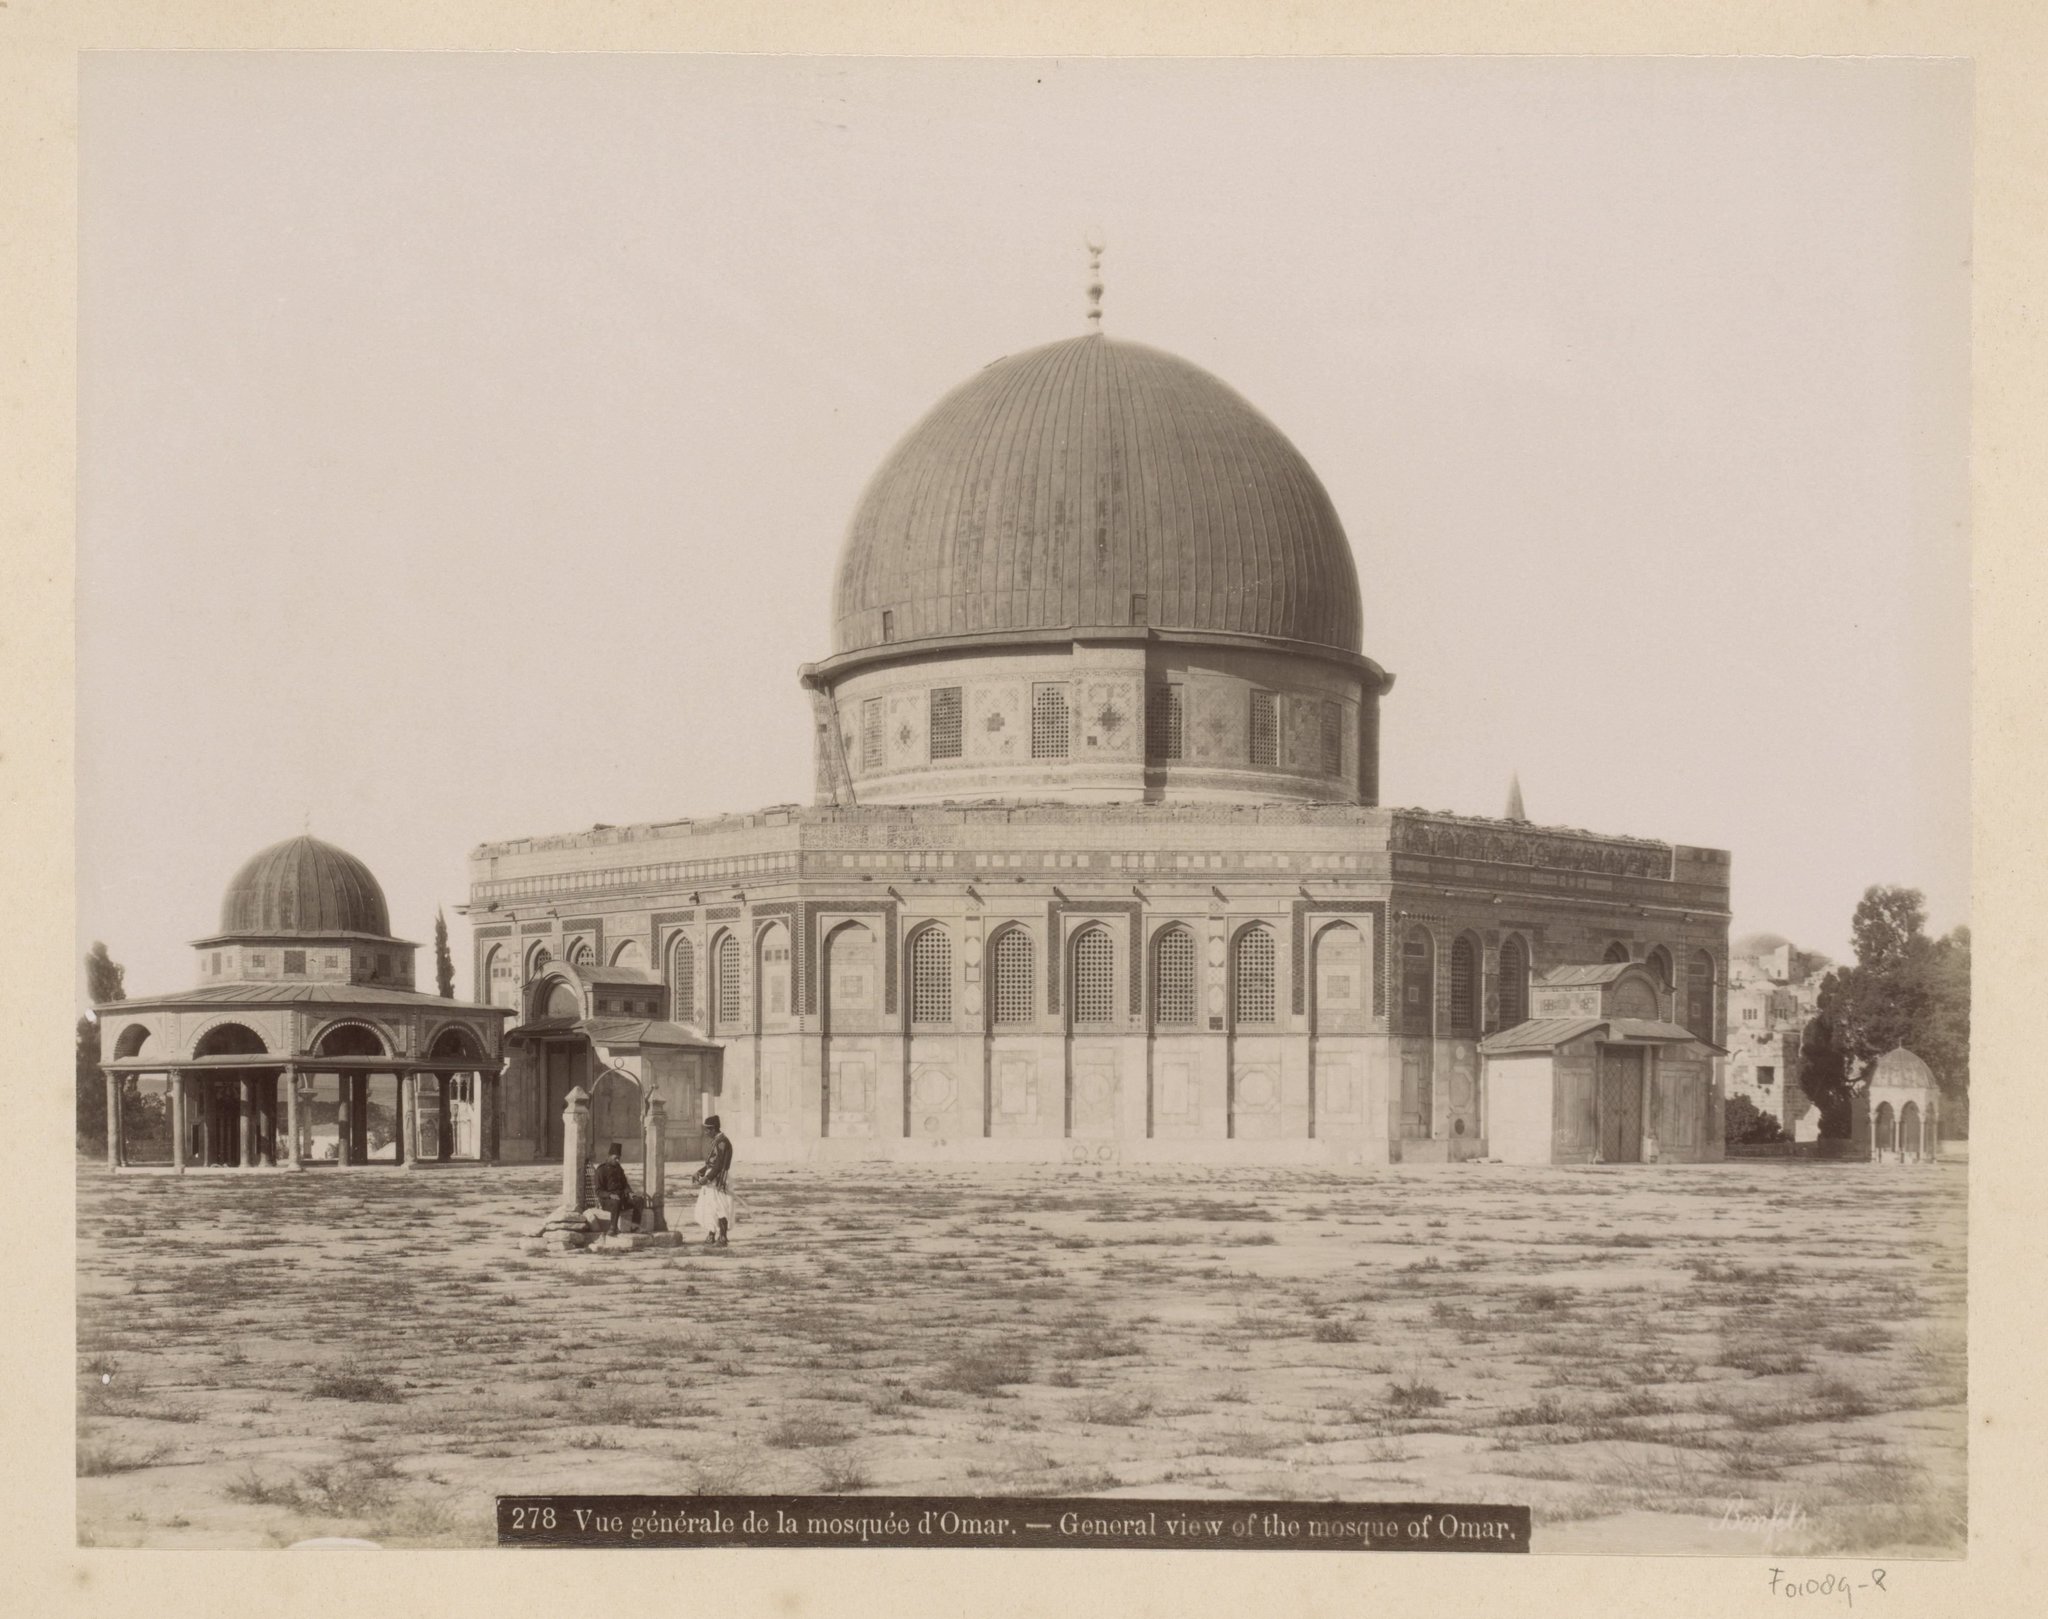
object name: photograph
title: Vue générale de la mosquée d'Omar. - General view of the mosque of Omar.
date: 1867-1895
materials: cardboard, paper, photographic support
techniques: albumen print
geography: tempelberg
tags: temple, shrine ~ islam, mohammedanism, dome ~ architecture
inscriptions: negative number: ‘278’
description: Onderdeel van Reisalbum met foto's van Jeruzalem en andere bijbelse plaatsen.